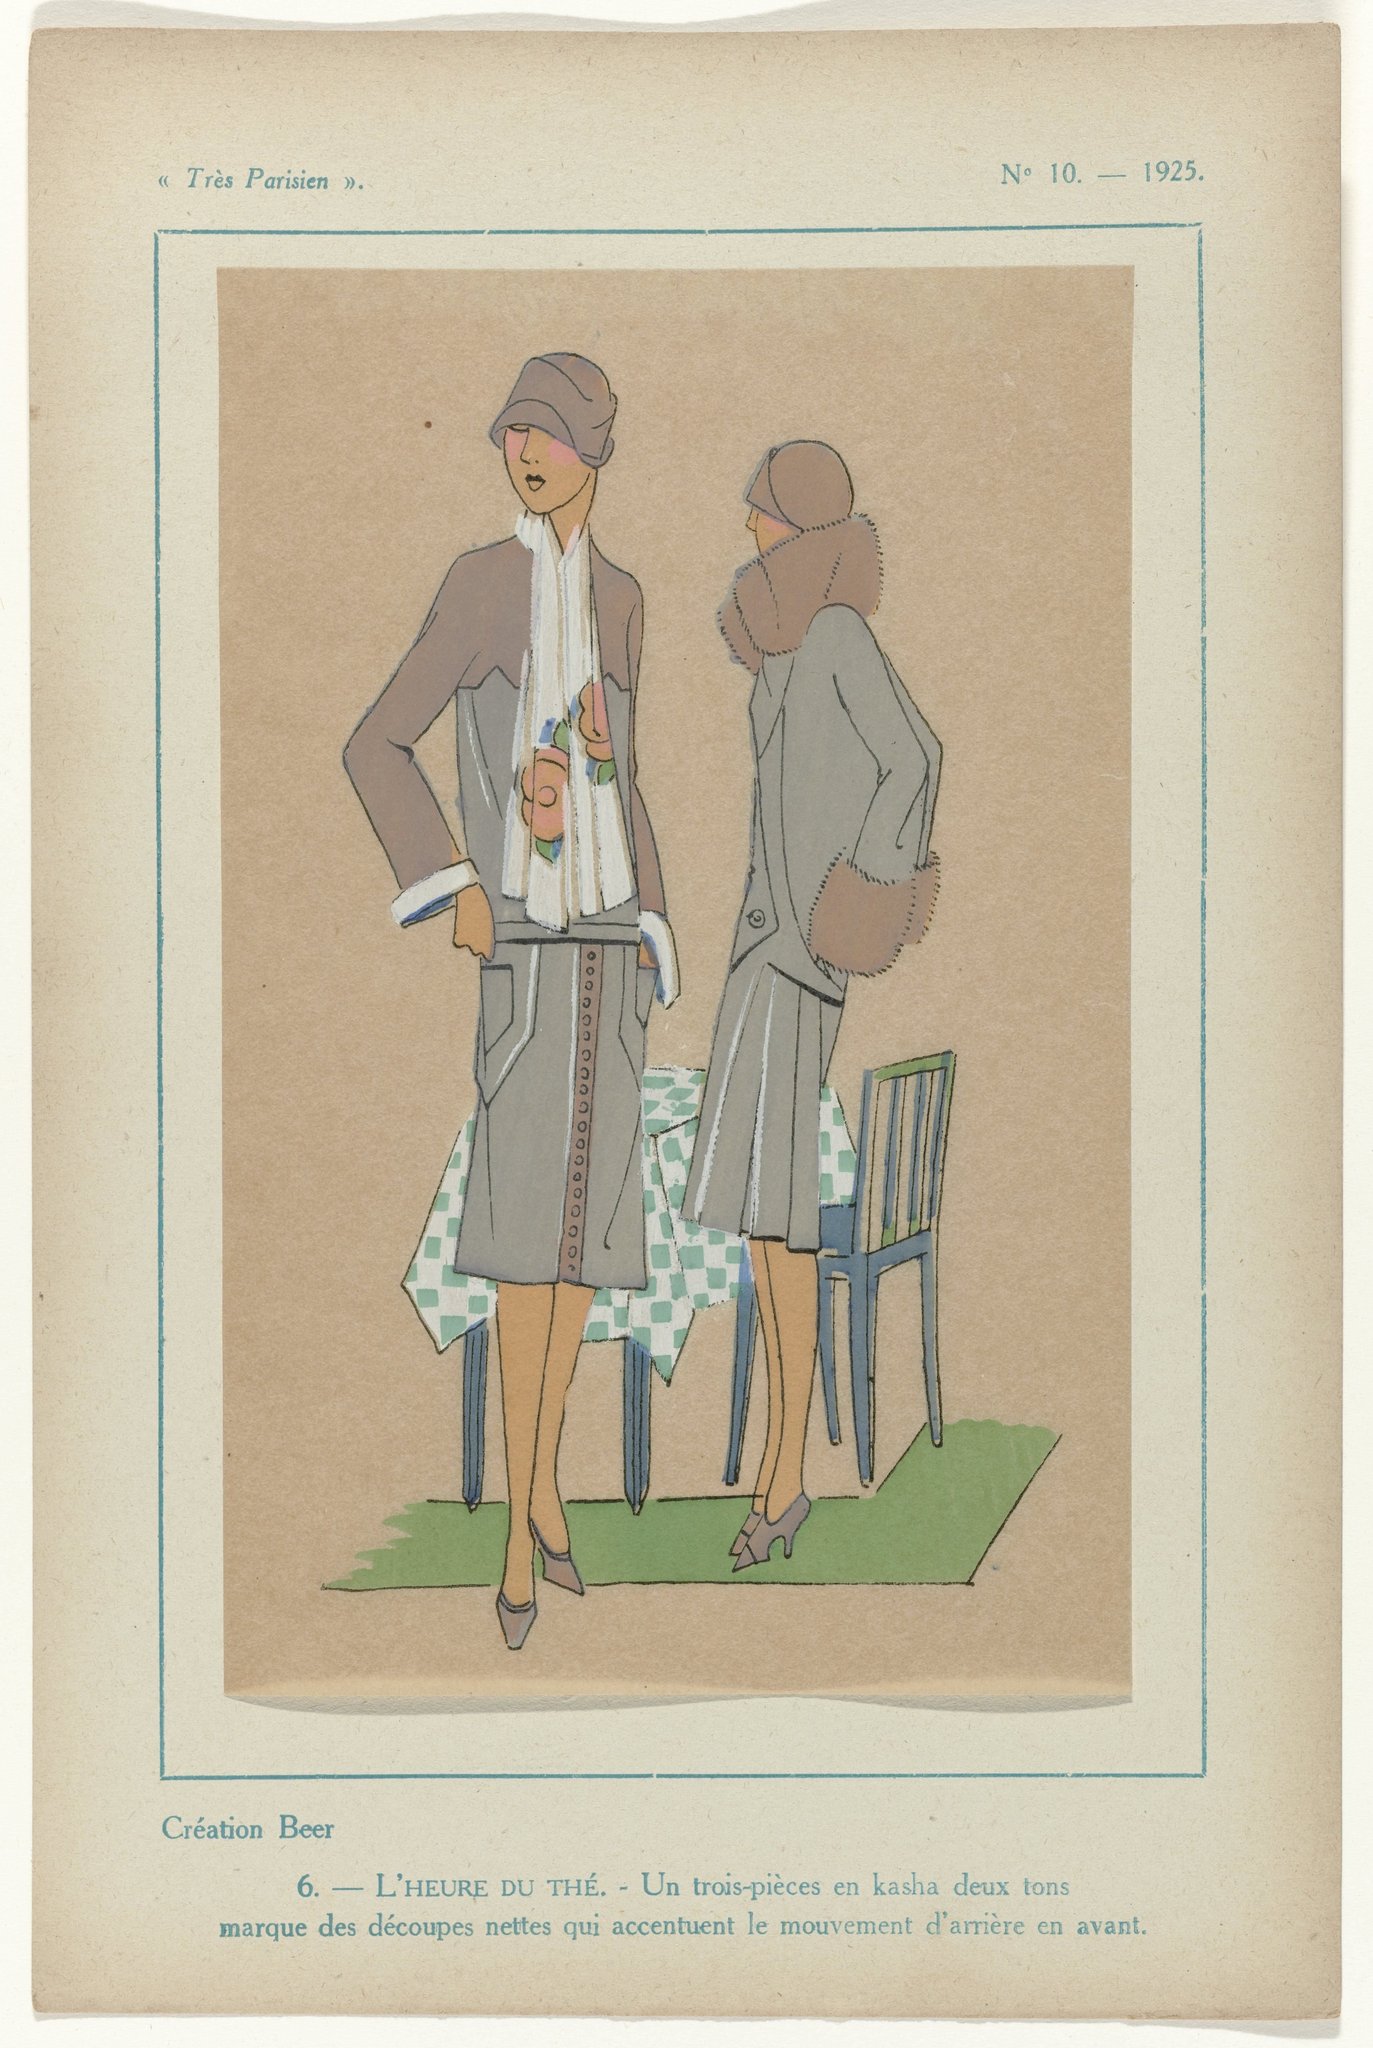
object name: fashion print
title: Très Parisien, 1925, No. 10, Pl. 6: Création Beer - L'HEURE DU THÉ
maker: g-p. joumard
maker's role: publisher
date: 1925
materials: paper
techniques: hand coloring, letterpress printing, lithography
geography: paris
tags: ensembles of pieces of clothing (three piece suit) (+ women's clothes), fashion plates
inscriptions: caption: ‘6. - L'HEURE DU THÉ. - Une panne dégradée, un velours souple et chatoyant, ombré du flamme au brun, fait un manteau froncé aux épaules et garni de fourrure.’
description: Drie-delig ensemble van 'kasha' voor de namiddag van modehuis Beer. Stoffen van Codau et Guillaume, Parijs. Prent uit het modetijdschrift Très Parisien...La Mode, Le Chic, L'Élégance (1920-1936)